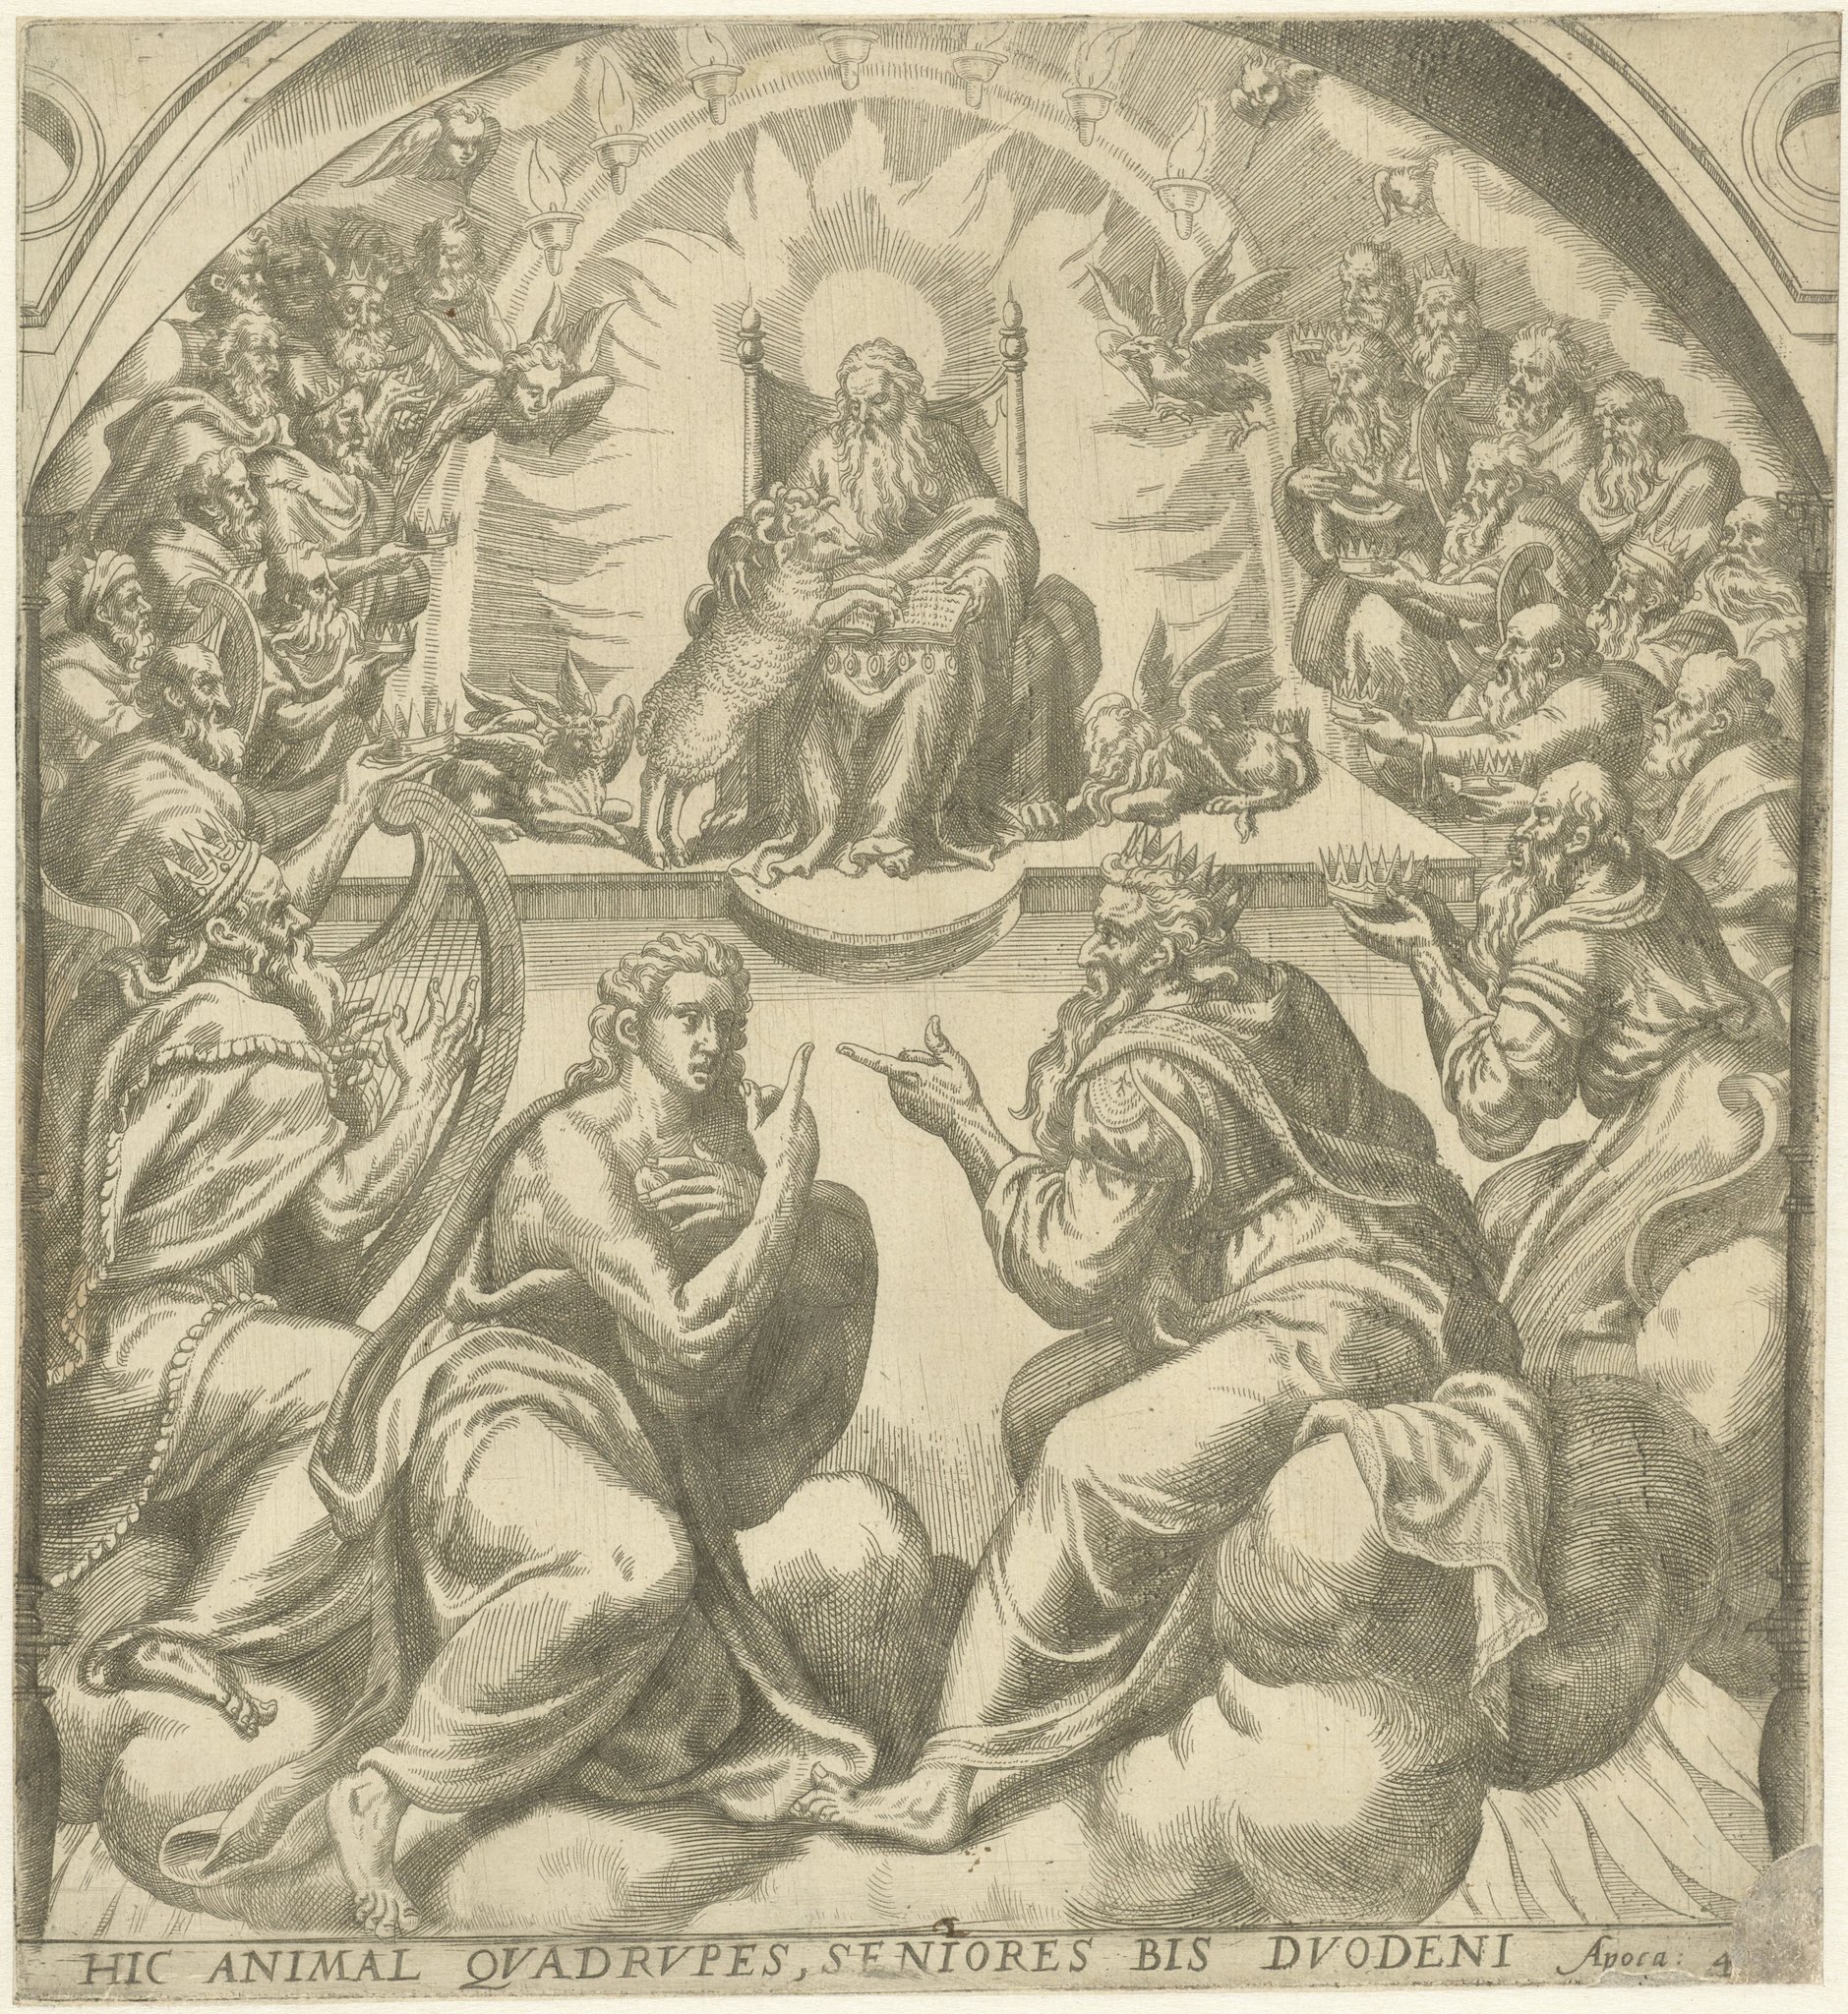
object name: print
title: Hic animal Qvadrvpes, seniores bis Dvodeni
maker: gerard van groeningen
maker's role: draughtsman, painter, print maker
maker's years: 1515-1599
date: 1563-1574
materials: paper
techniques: engraving, etching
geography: antwerp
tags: god on his throne, surrounded by the twenty-four elders (wearing crowns and playing harps) and the four beasts, the vision of the lamb and the book with the seven seals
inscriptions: collector's mark: Lugt 2228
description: Op de voorgrond de apostel Johannes. Hij wijst naar de hemeltroon met God en de vier apocalyptische dieren. Boven de troon de zeven fakkels die symbool staan voor de zeven gaven van de Heilige Geest. Het zevengehoornde Lam Gods staat bij de troon en opent het boek met de zeven zegels. Rondom de troon de vierentwintig oudsten, ieder met een gouden kroon en een harp (Op. 4: 2-8, Op. 5:6-14).